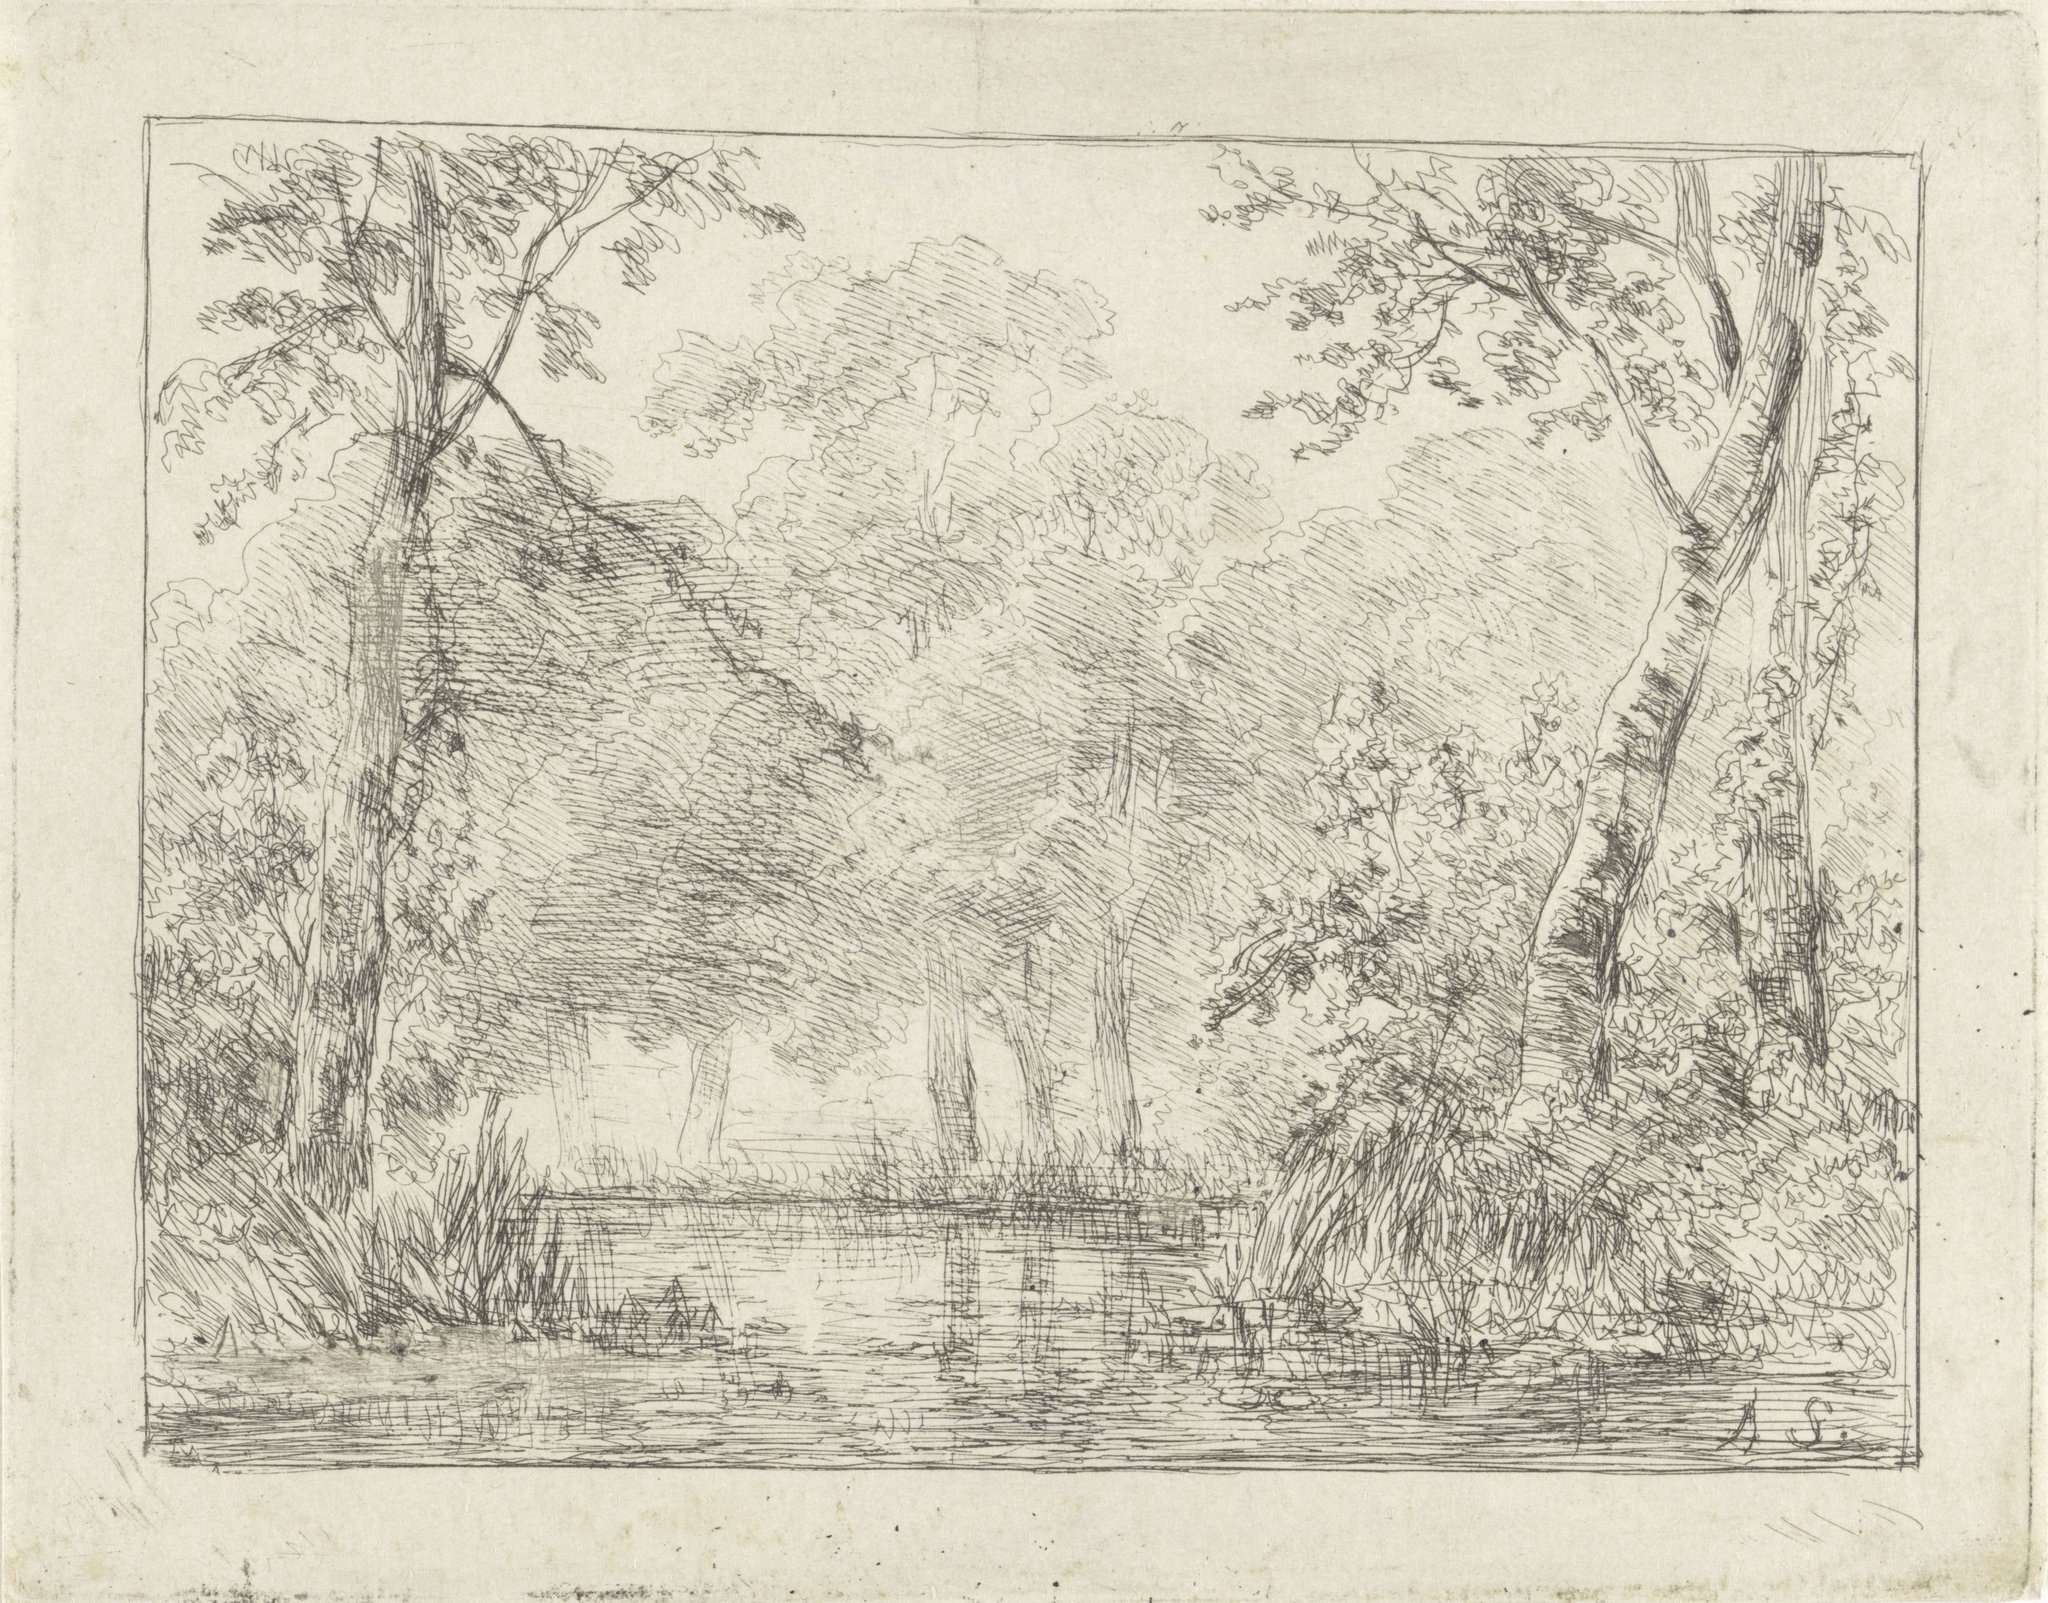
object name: print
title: Bosgezicht met vijver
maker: andreas schelfhout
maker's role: draughtsman, painter, print maker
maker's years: 1787-1870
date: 1852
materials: paper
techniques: etching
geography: the hague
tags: forest, wood, pond, pool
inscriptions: collector's mark: Lugt 2228